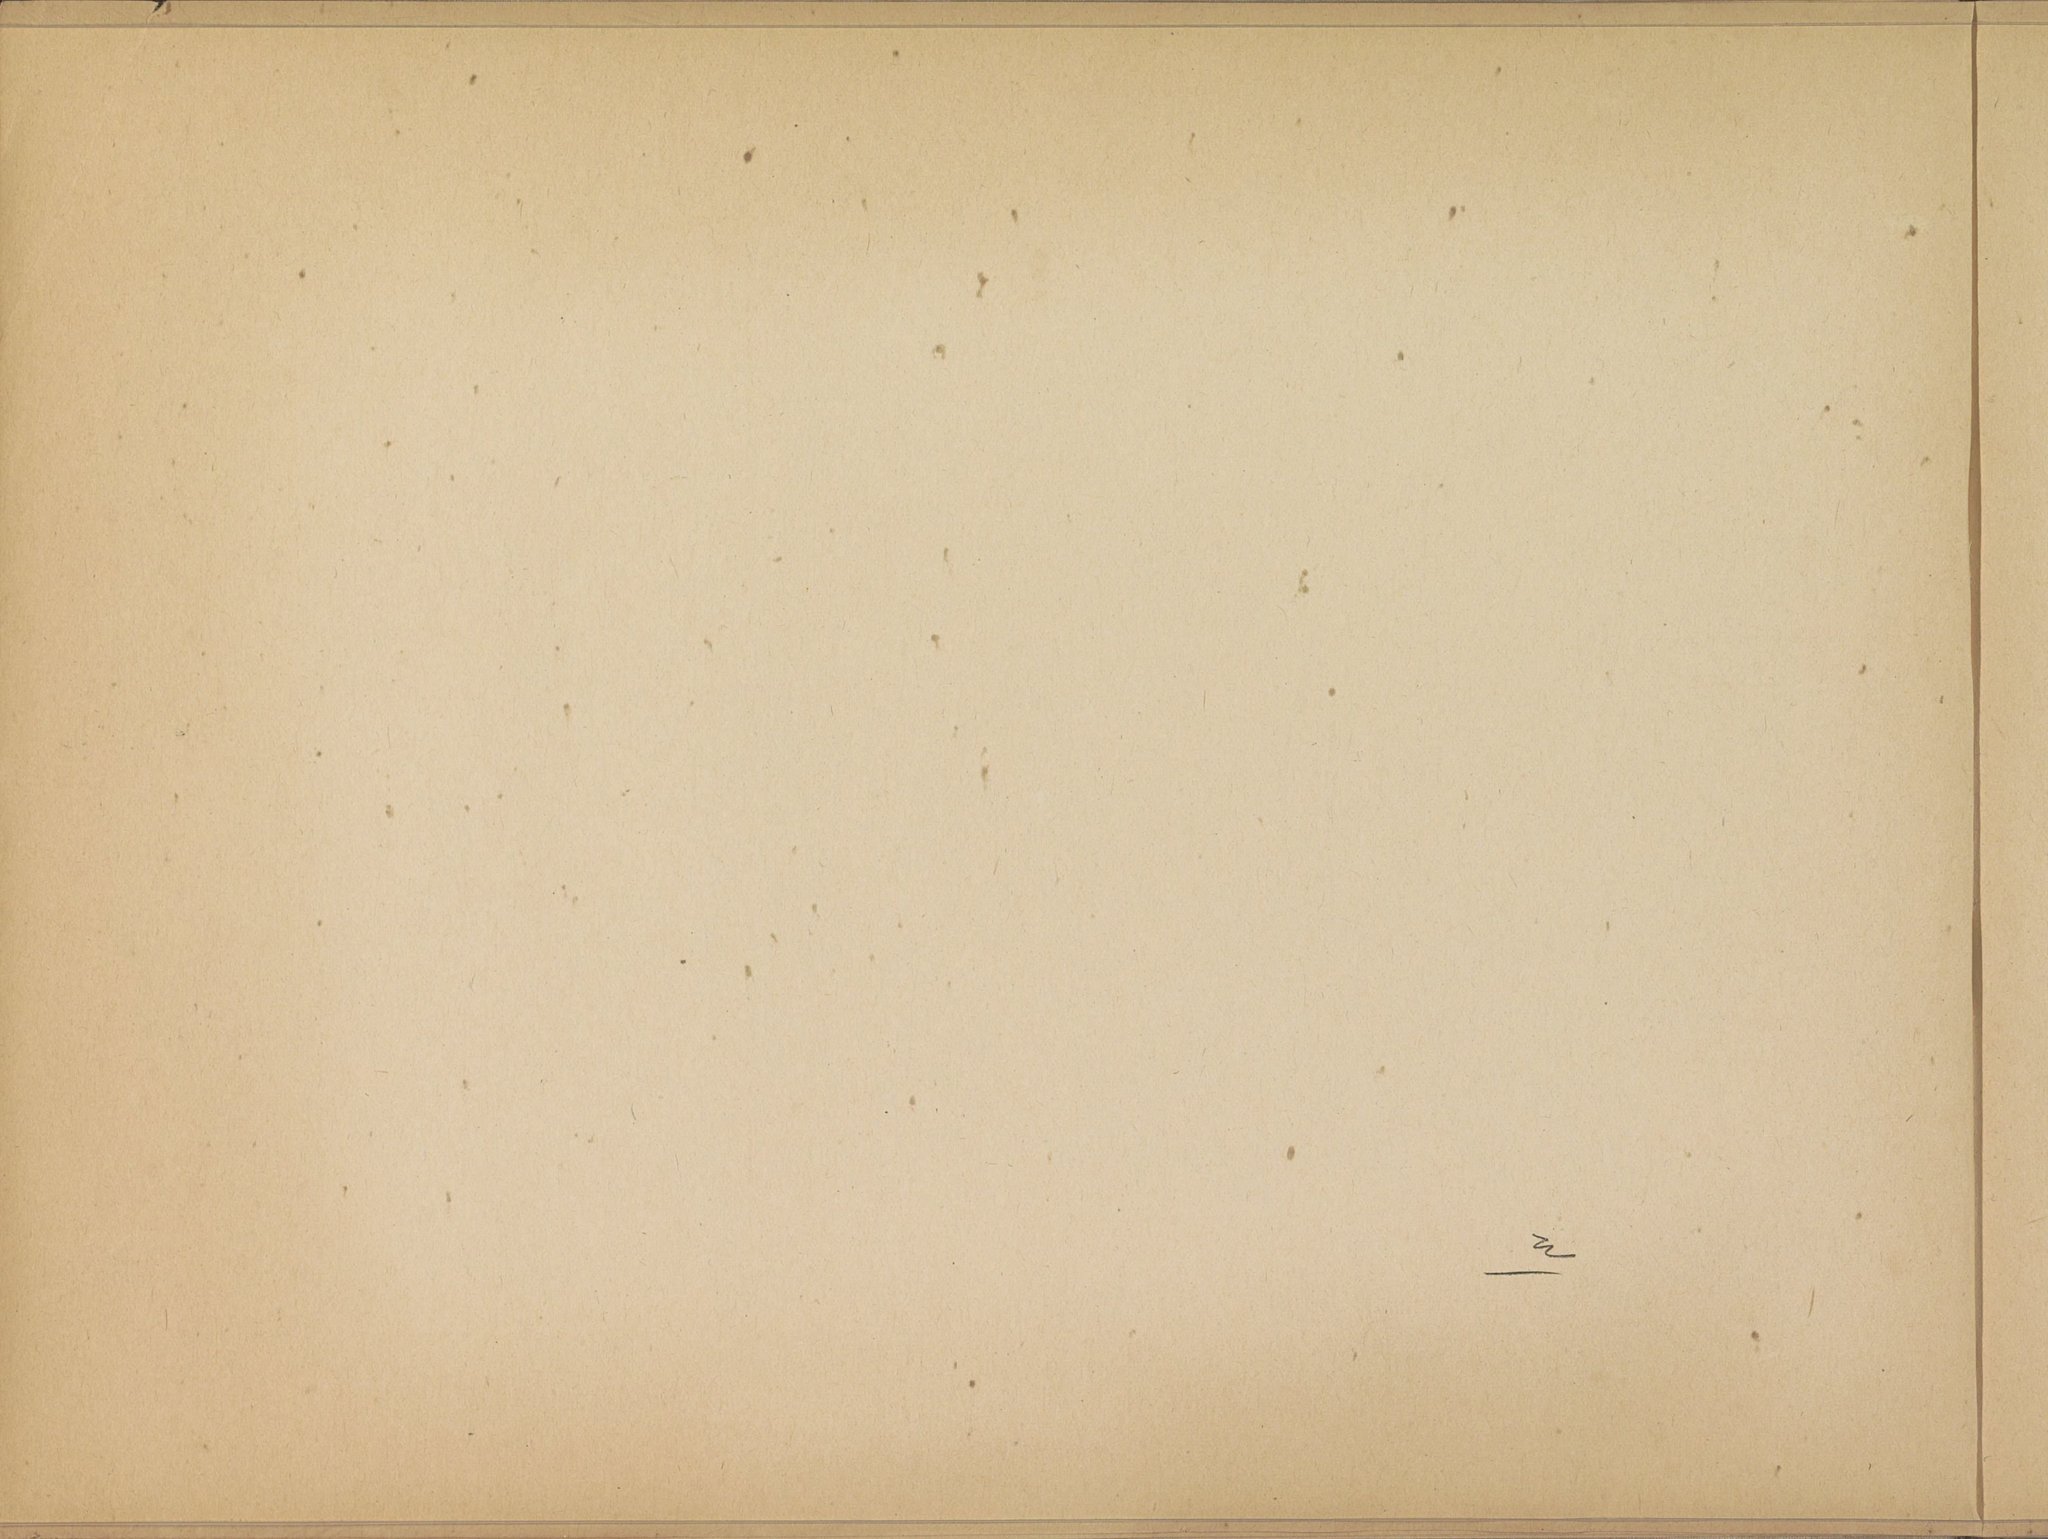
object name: sketchbook leaf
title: Notitie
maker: cornelis vreedenburgh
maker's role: draughtsman, print maker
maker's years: 1880-1946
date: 1890-1946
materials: chalk, paper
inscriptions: annotation: ‘W/’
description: Pagina 4 verso uit een schetsboek met 22 bladen.